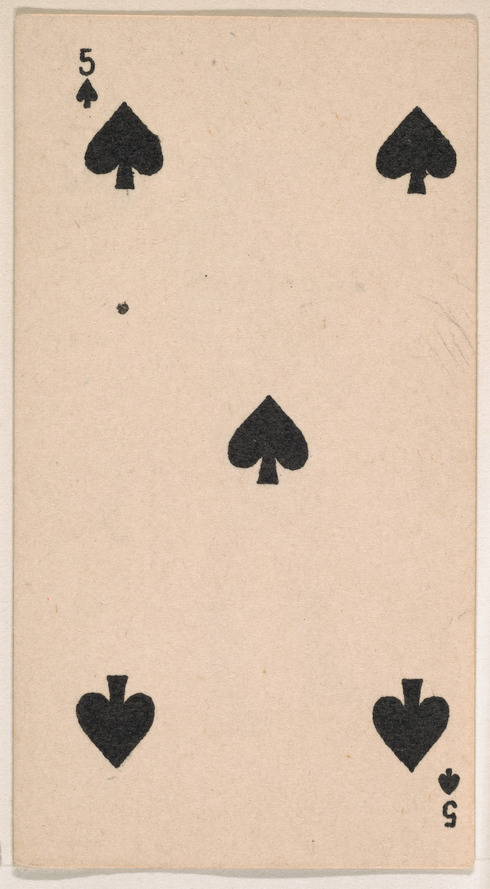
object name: print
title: Five of Spades, from the Transparent Playing Cards series (N220) issued by Kinney Bros.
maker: kinney brothers tobacco company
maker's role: publisher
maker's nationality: american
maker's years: 1869-2011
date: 1888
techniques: color lithograph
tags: playing cards